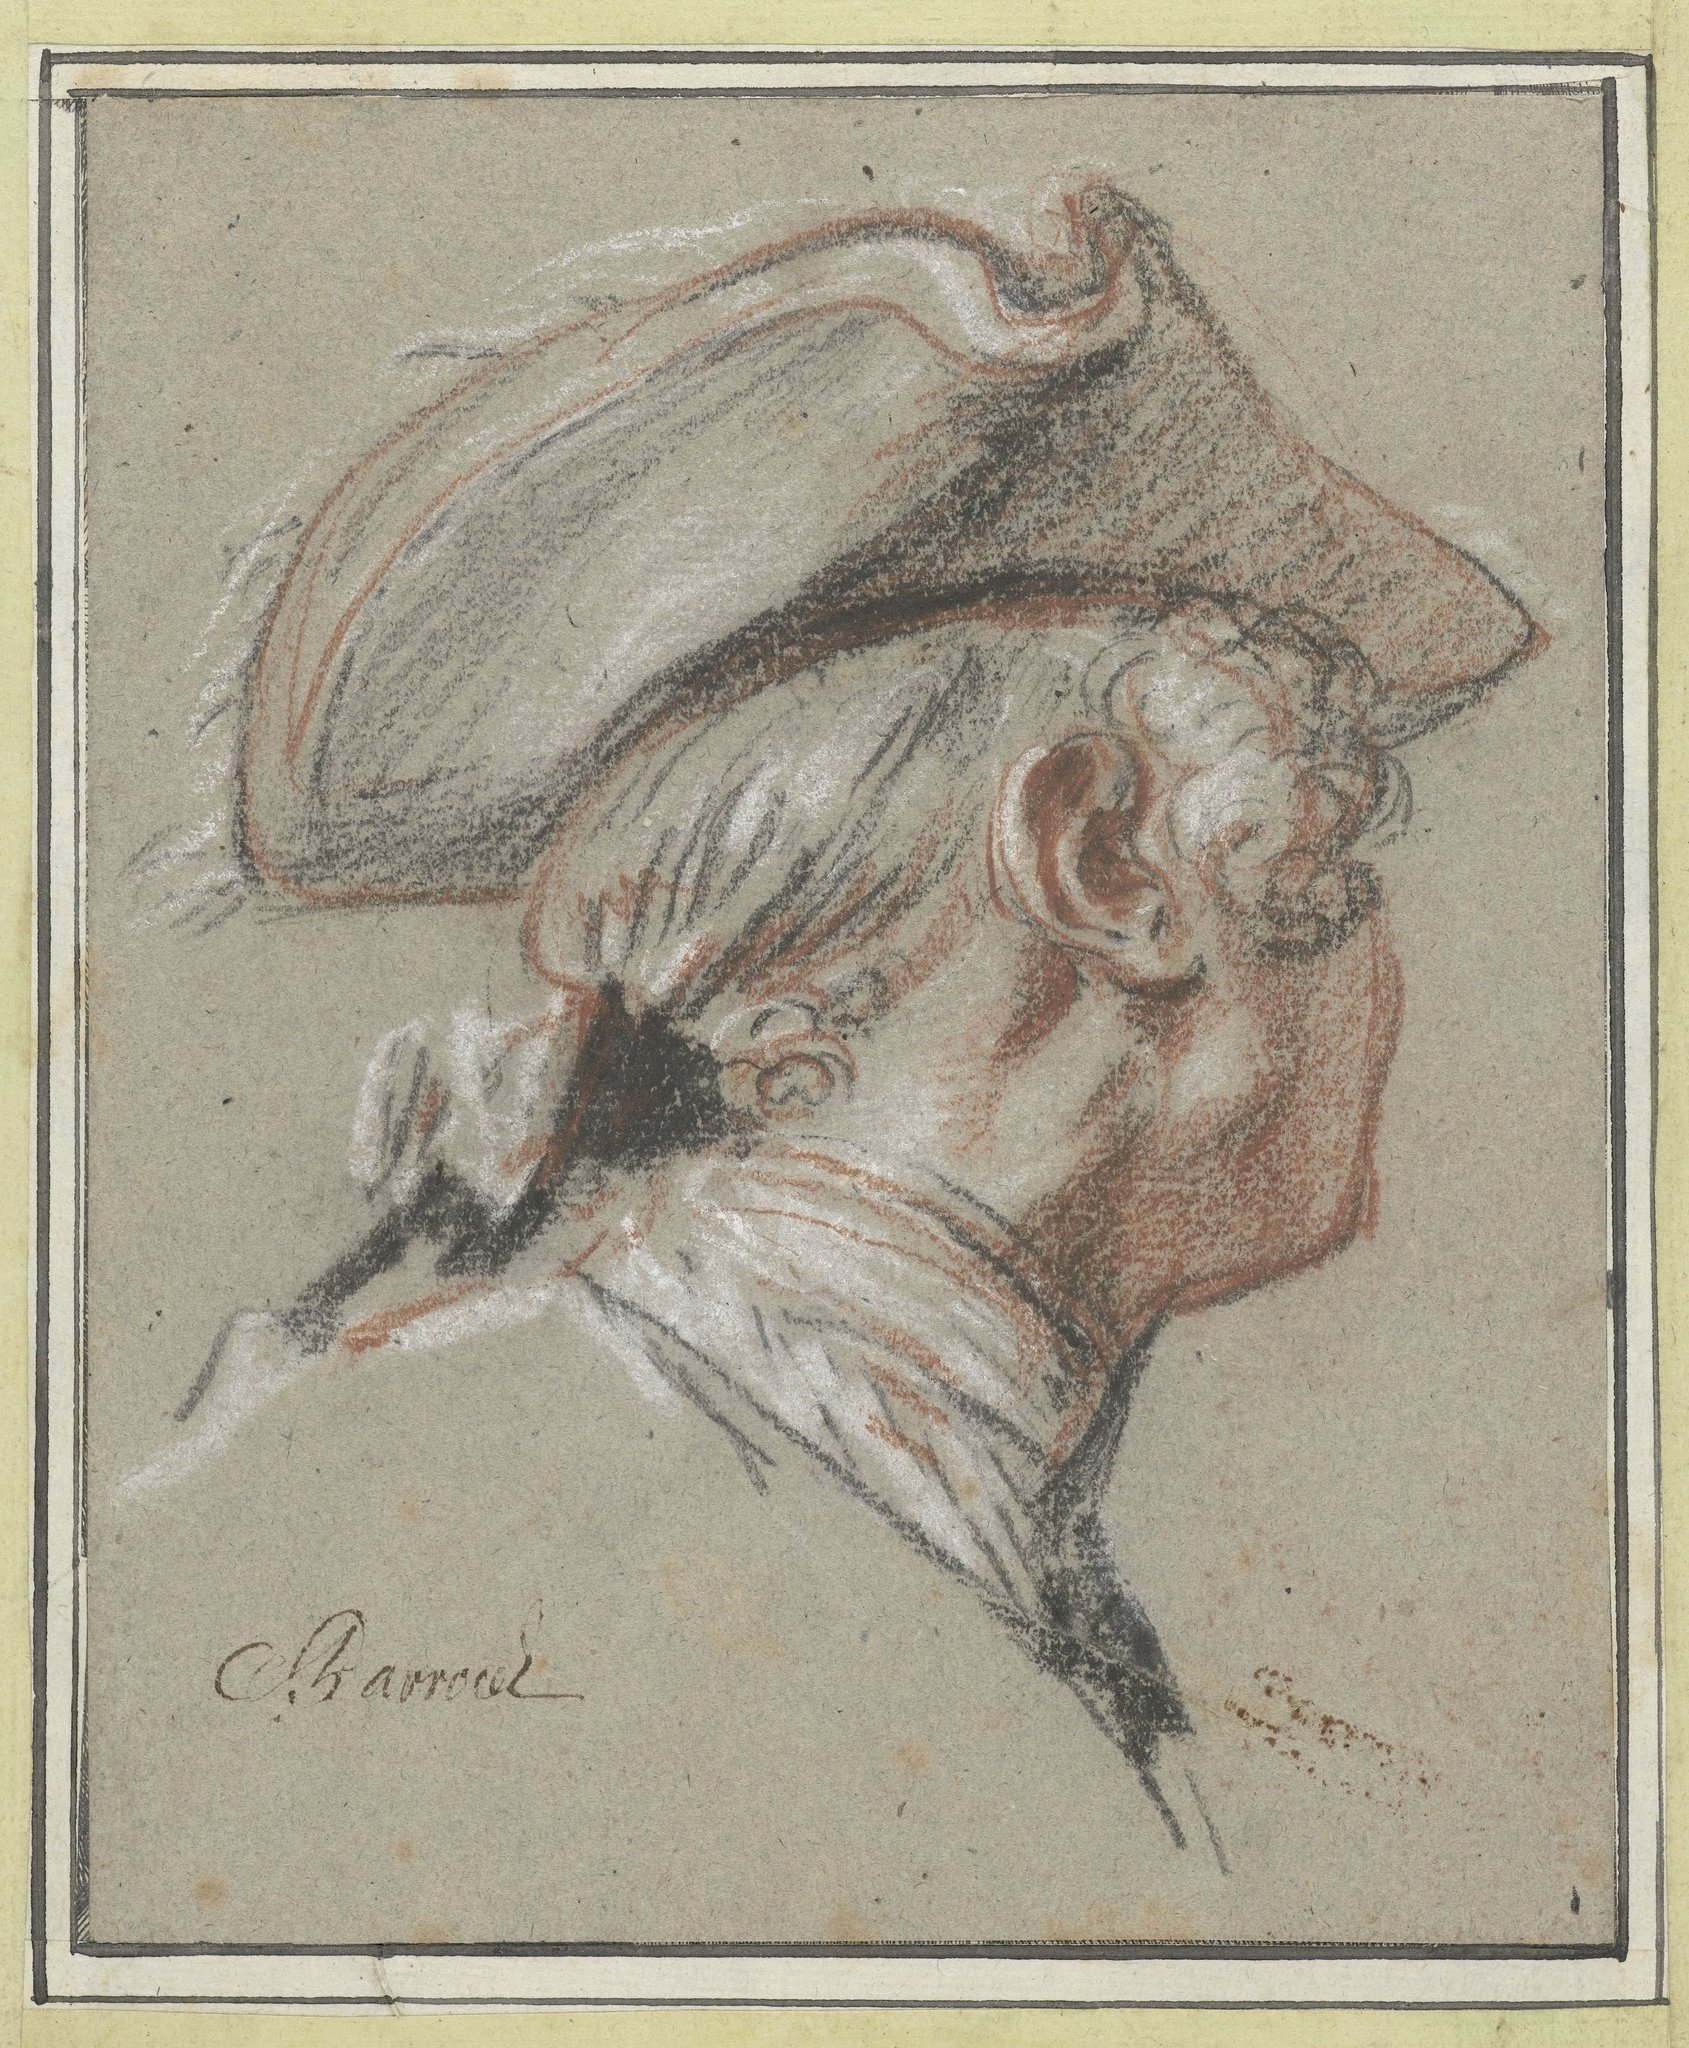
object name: drawing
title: Study of a Head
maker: charles parrocel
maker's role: draughtsman, painter, print maker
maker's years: 1688-1752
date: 1737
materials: chalk, paper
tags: head-gear: tricorn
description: Charles Parrocel was a cavalryman in his younger years and thus knew the military world inside out. This served him in good stead in his later career as a painter of battle scenes, for which the sheet on view here served as a preparatory drawing. Using the trois crayons technique, Parrocel deftly drew the averted head – in profil perdu – of a French officer, as indicated by the tricorne and wig.